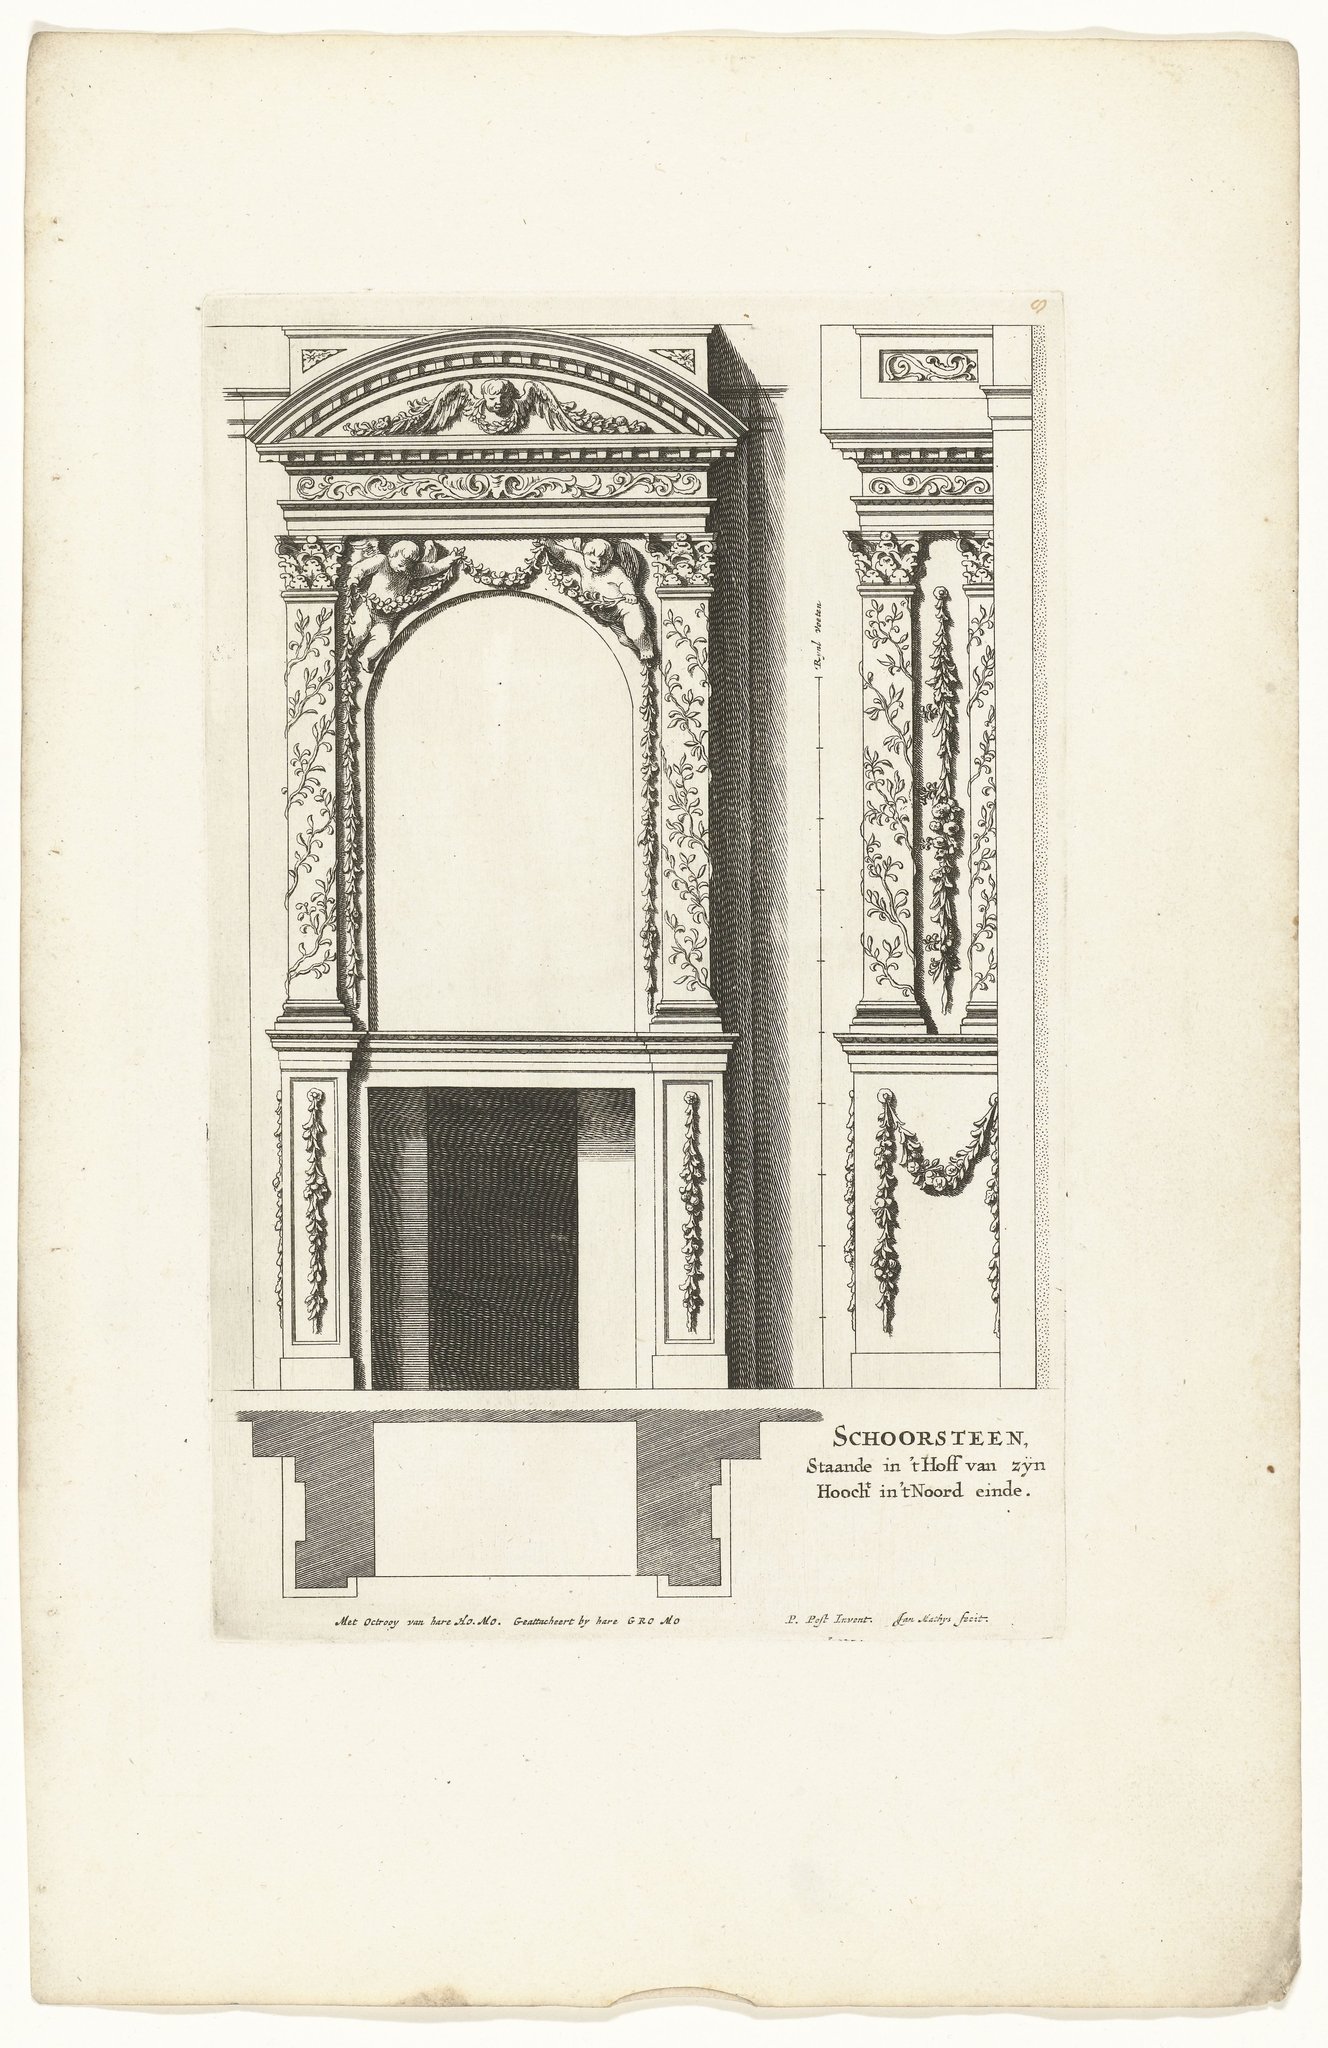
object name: ornament print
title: Schoorsteen, Staende in 't Hoff van zyn Hoocht. in 't Noord einde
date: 1664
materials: paper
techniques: engraving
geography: the hague